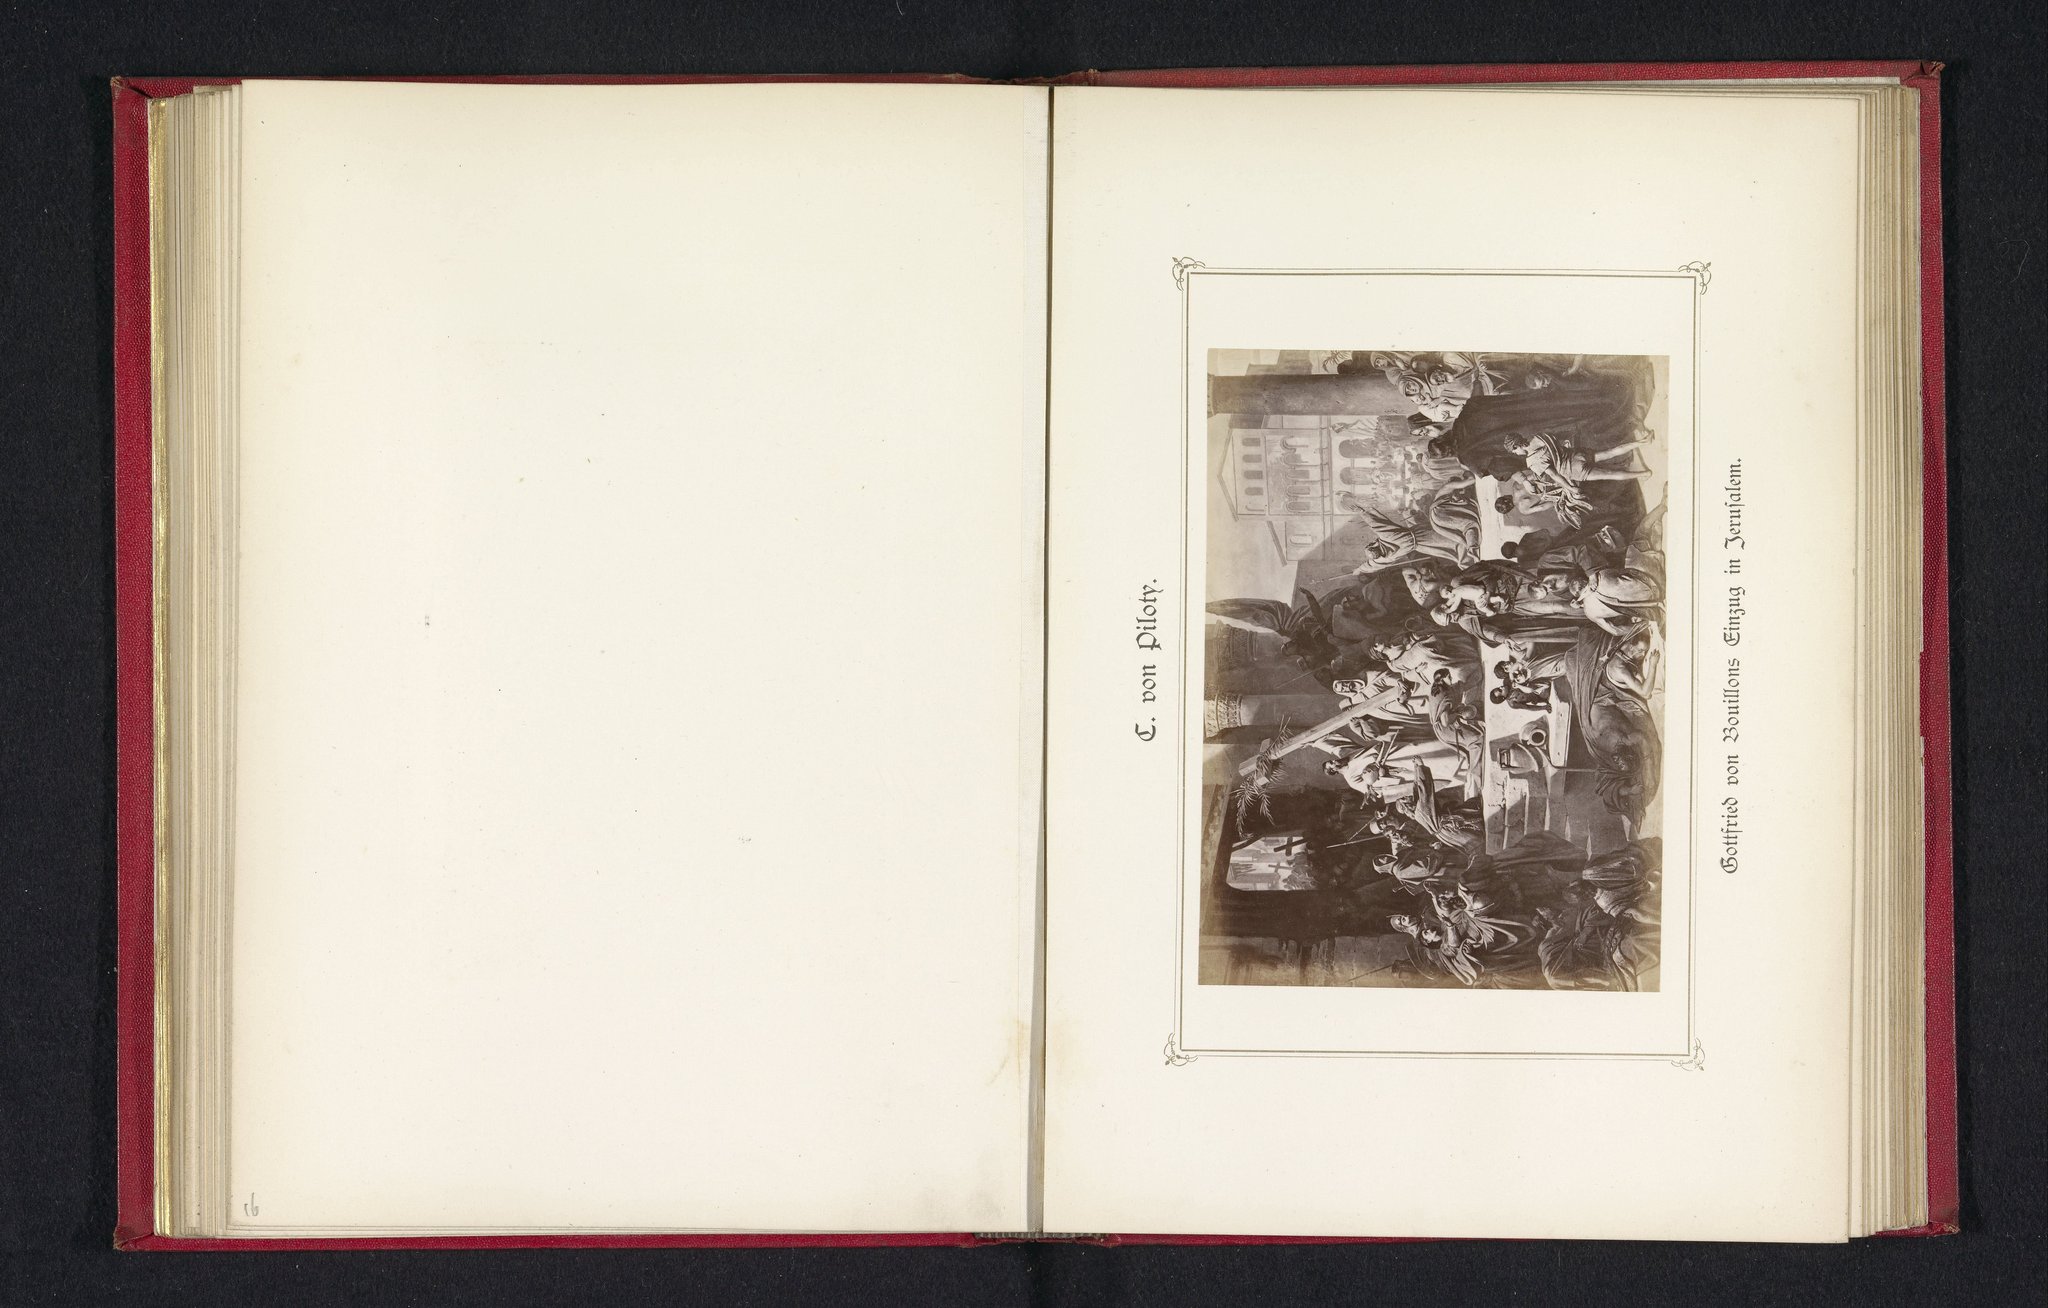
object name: page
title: Gottfried von Bouillons Einzug in Jeruzalem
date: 1875-1880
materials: photographic support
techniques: albumen print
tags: godfrey of bouillon, march into the conquered place